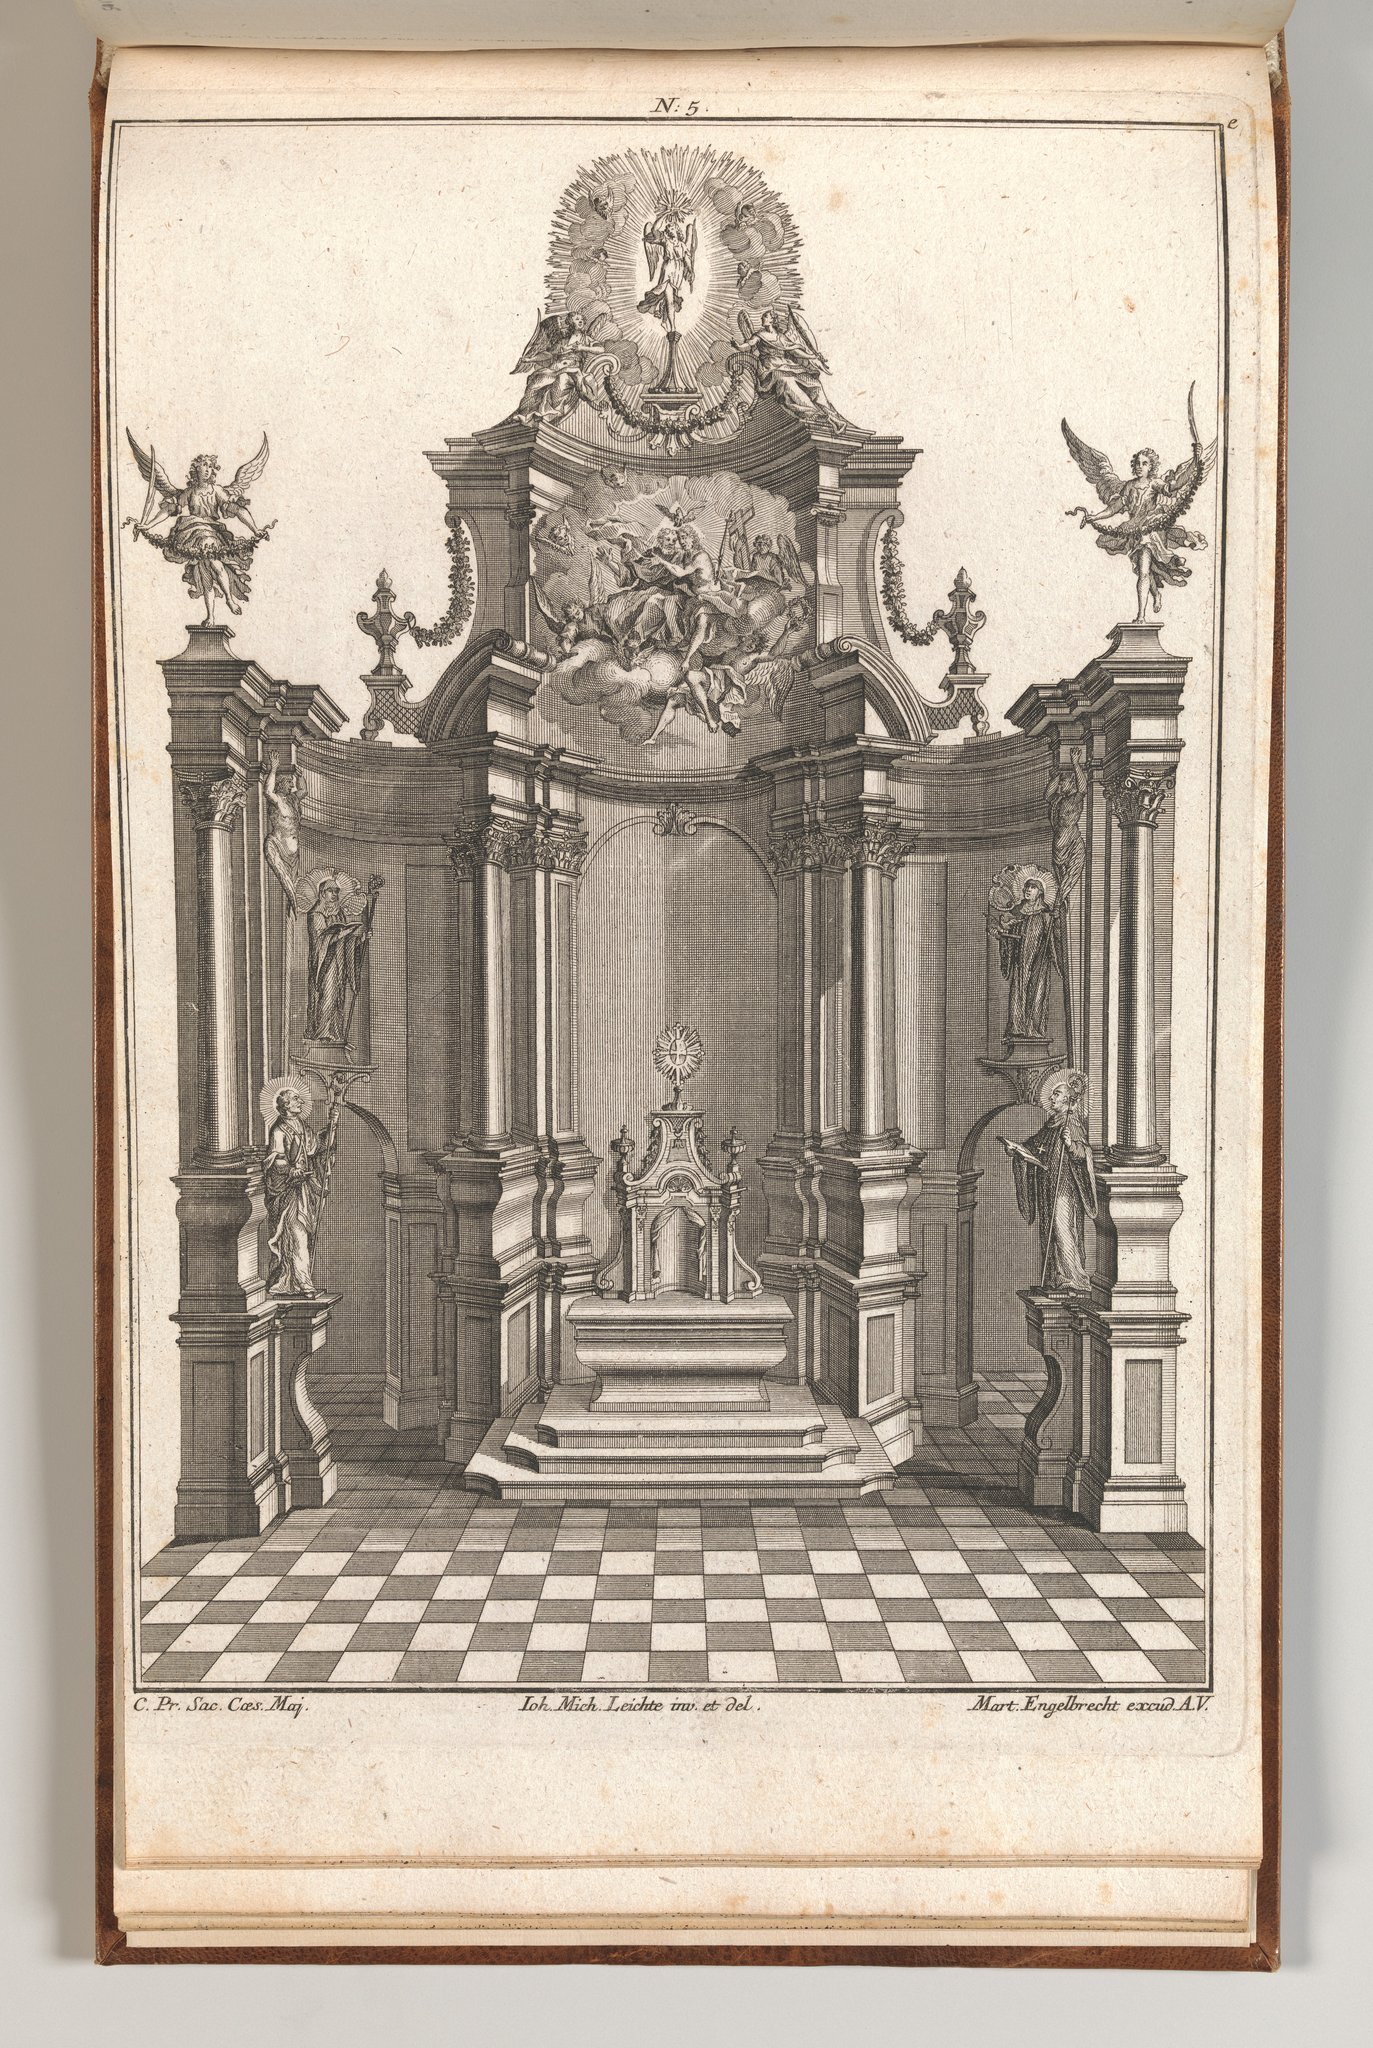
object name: album print ornament architecture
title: Design for a Monumental Altar, Plate e from 'Unterschiedliche Neu Inventierte Altäre mit darzu gehörigen Profillen u. Grundrißen.'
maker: johann michael leüchte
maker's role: artist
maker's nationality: german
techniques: etching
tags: altars,monuments,angels,reliquaries